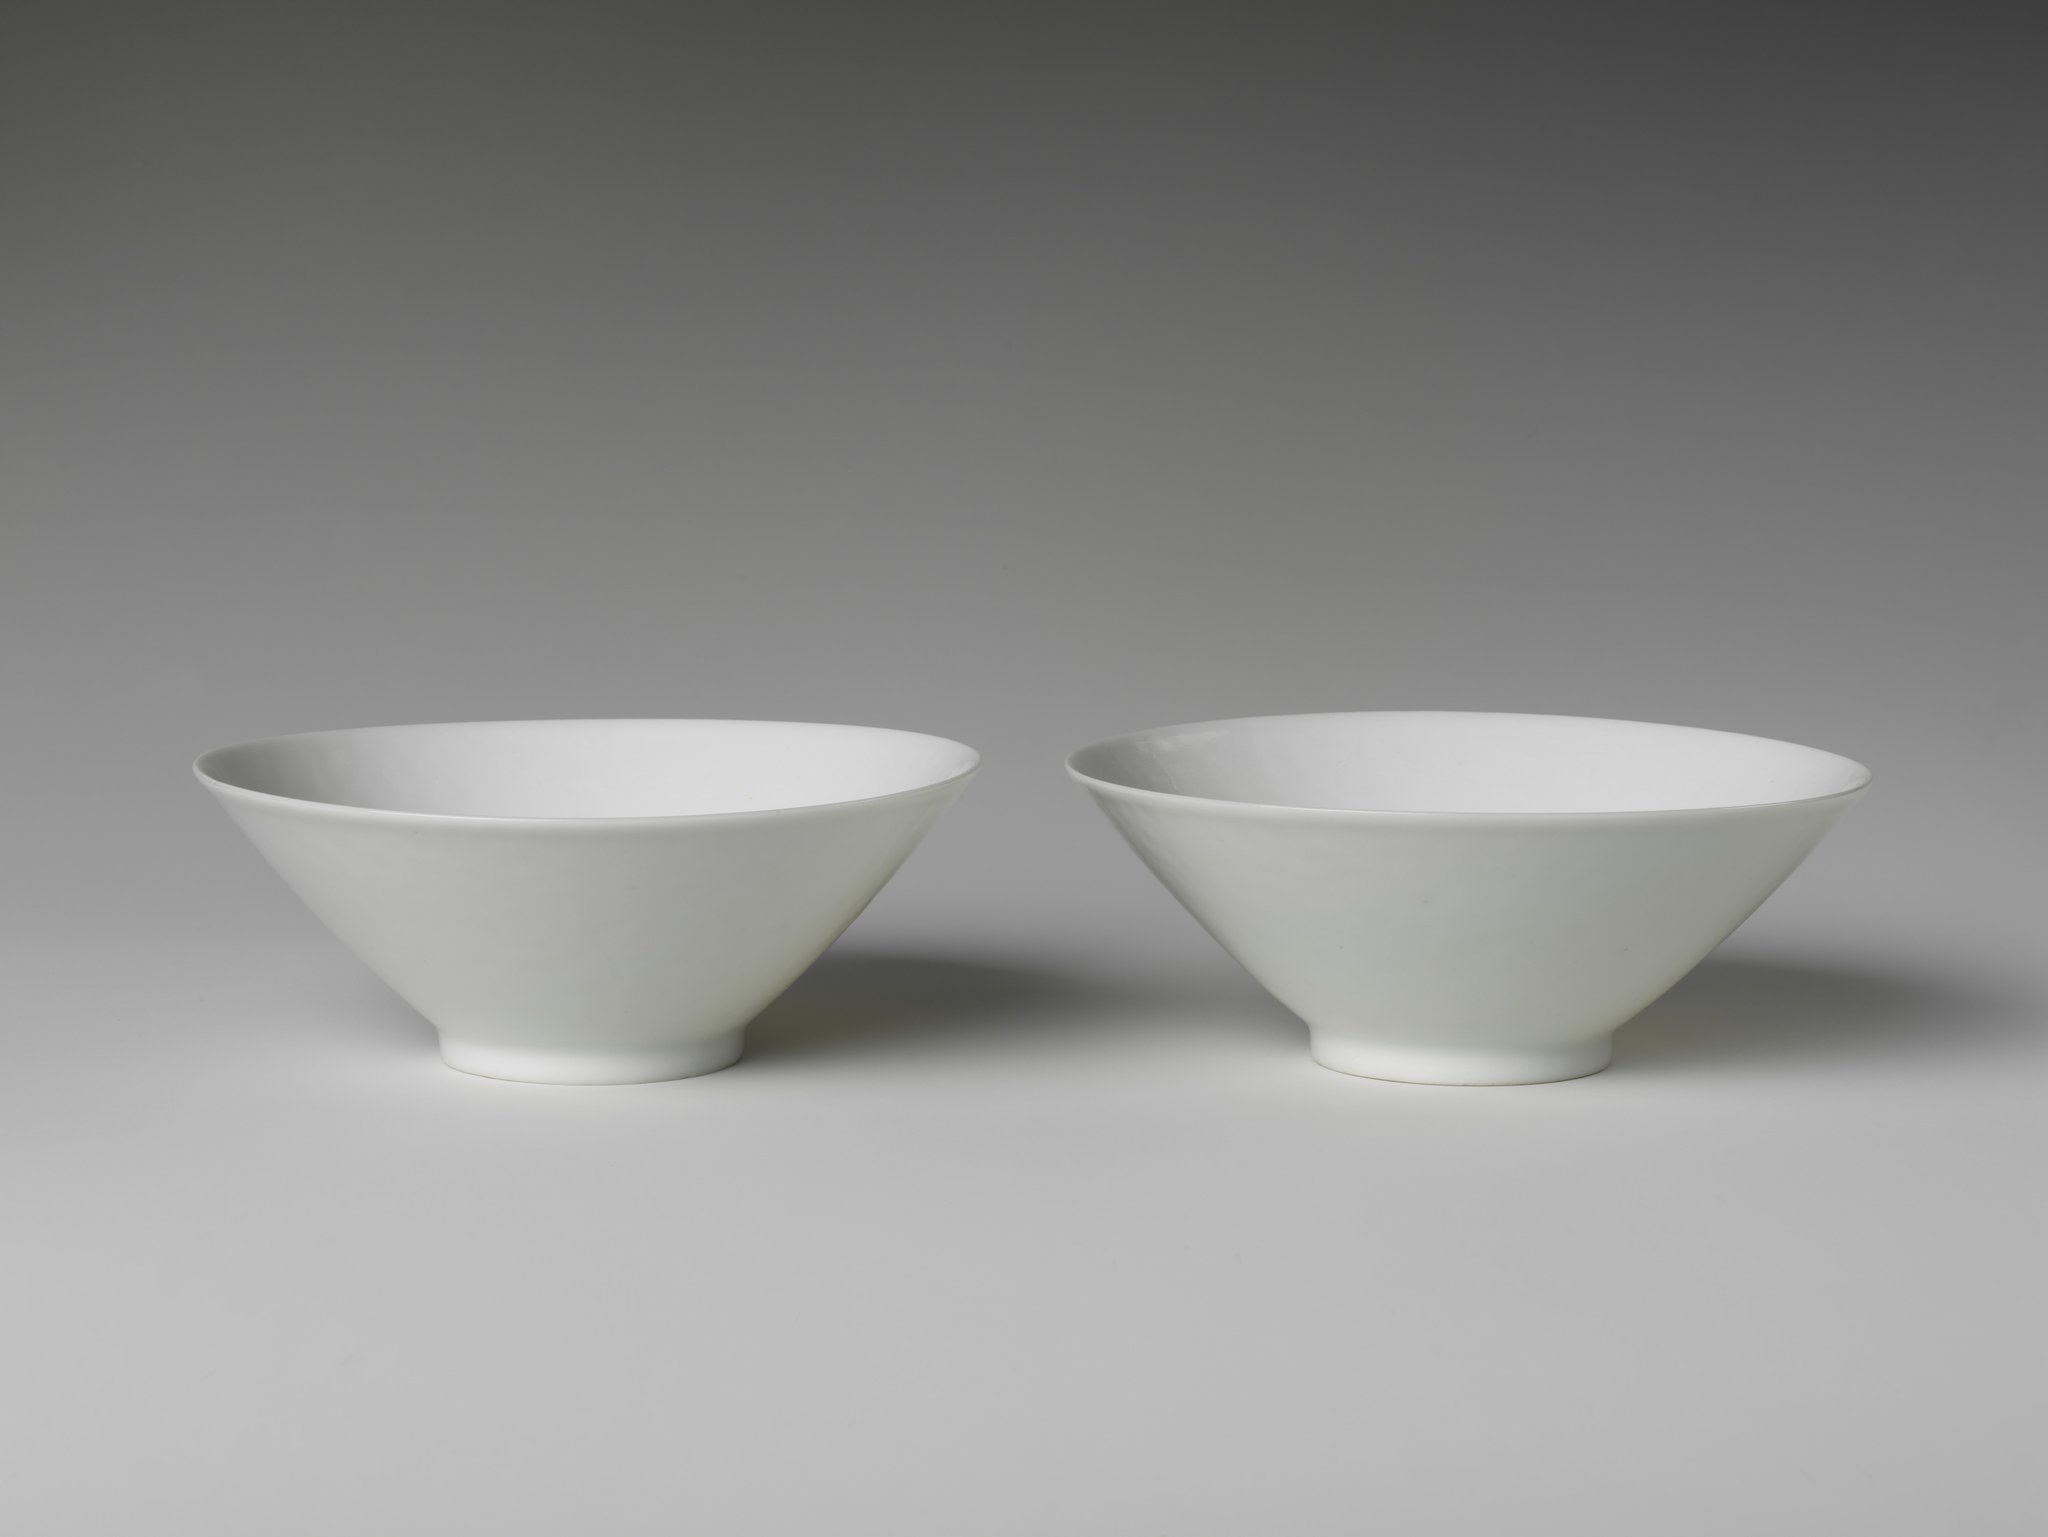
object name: bowl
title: Bowl with dragons (one of a pair)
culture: chinese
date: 1701-1733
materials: glaze, porcelain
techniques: incising